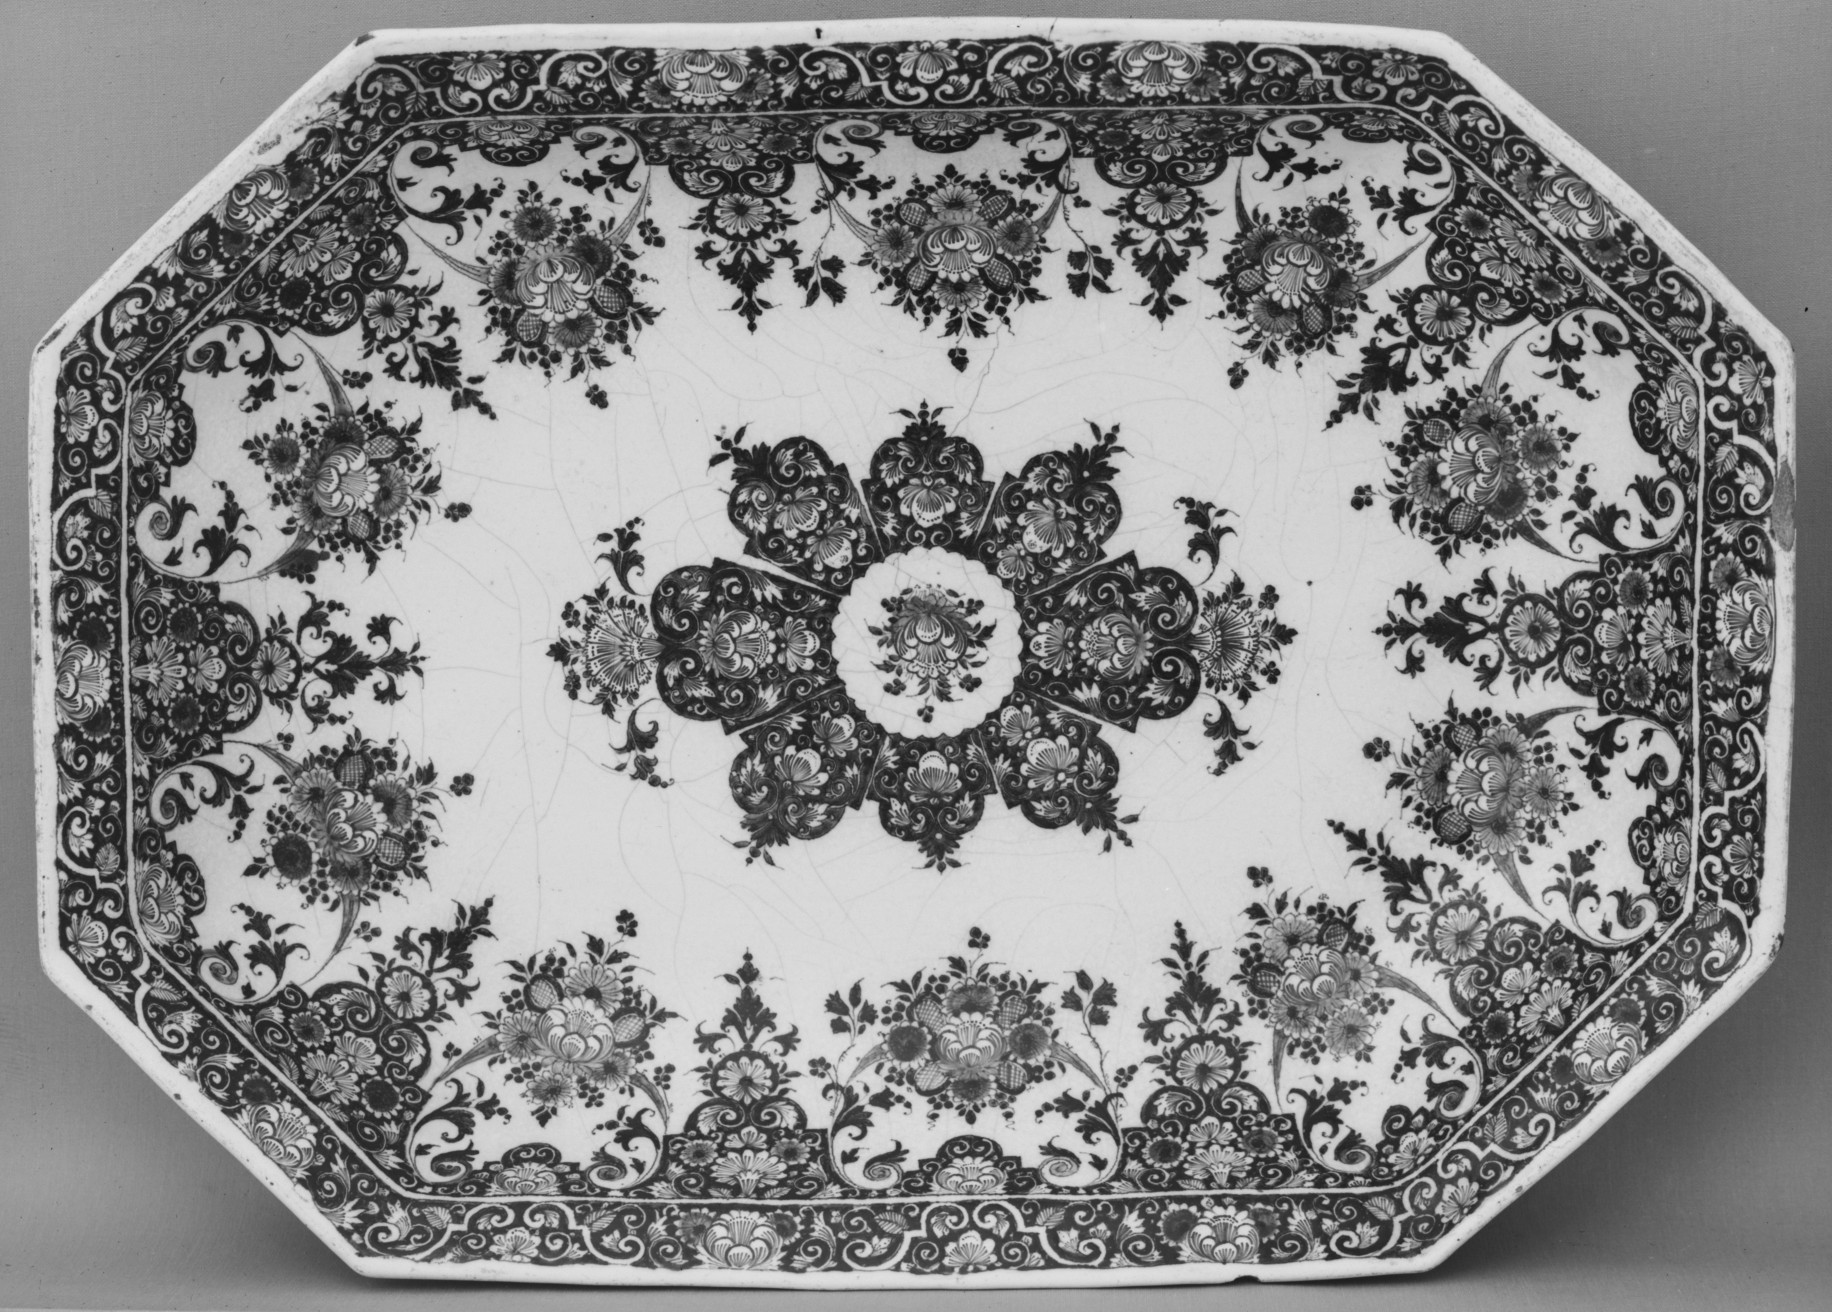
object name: plateau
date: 1705-1720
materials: faience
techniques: glazing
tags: flowers